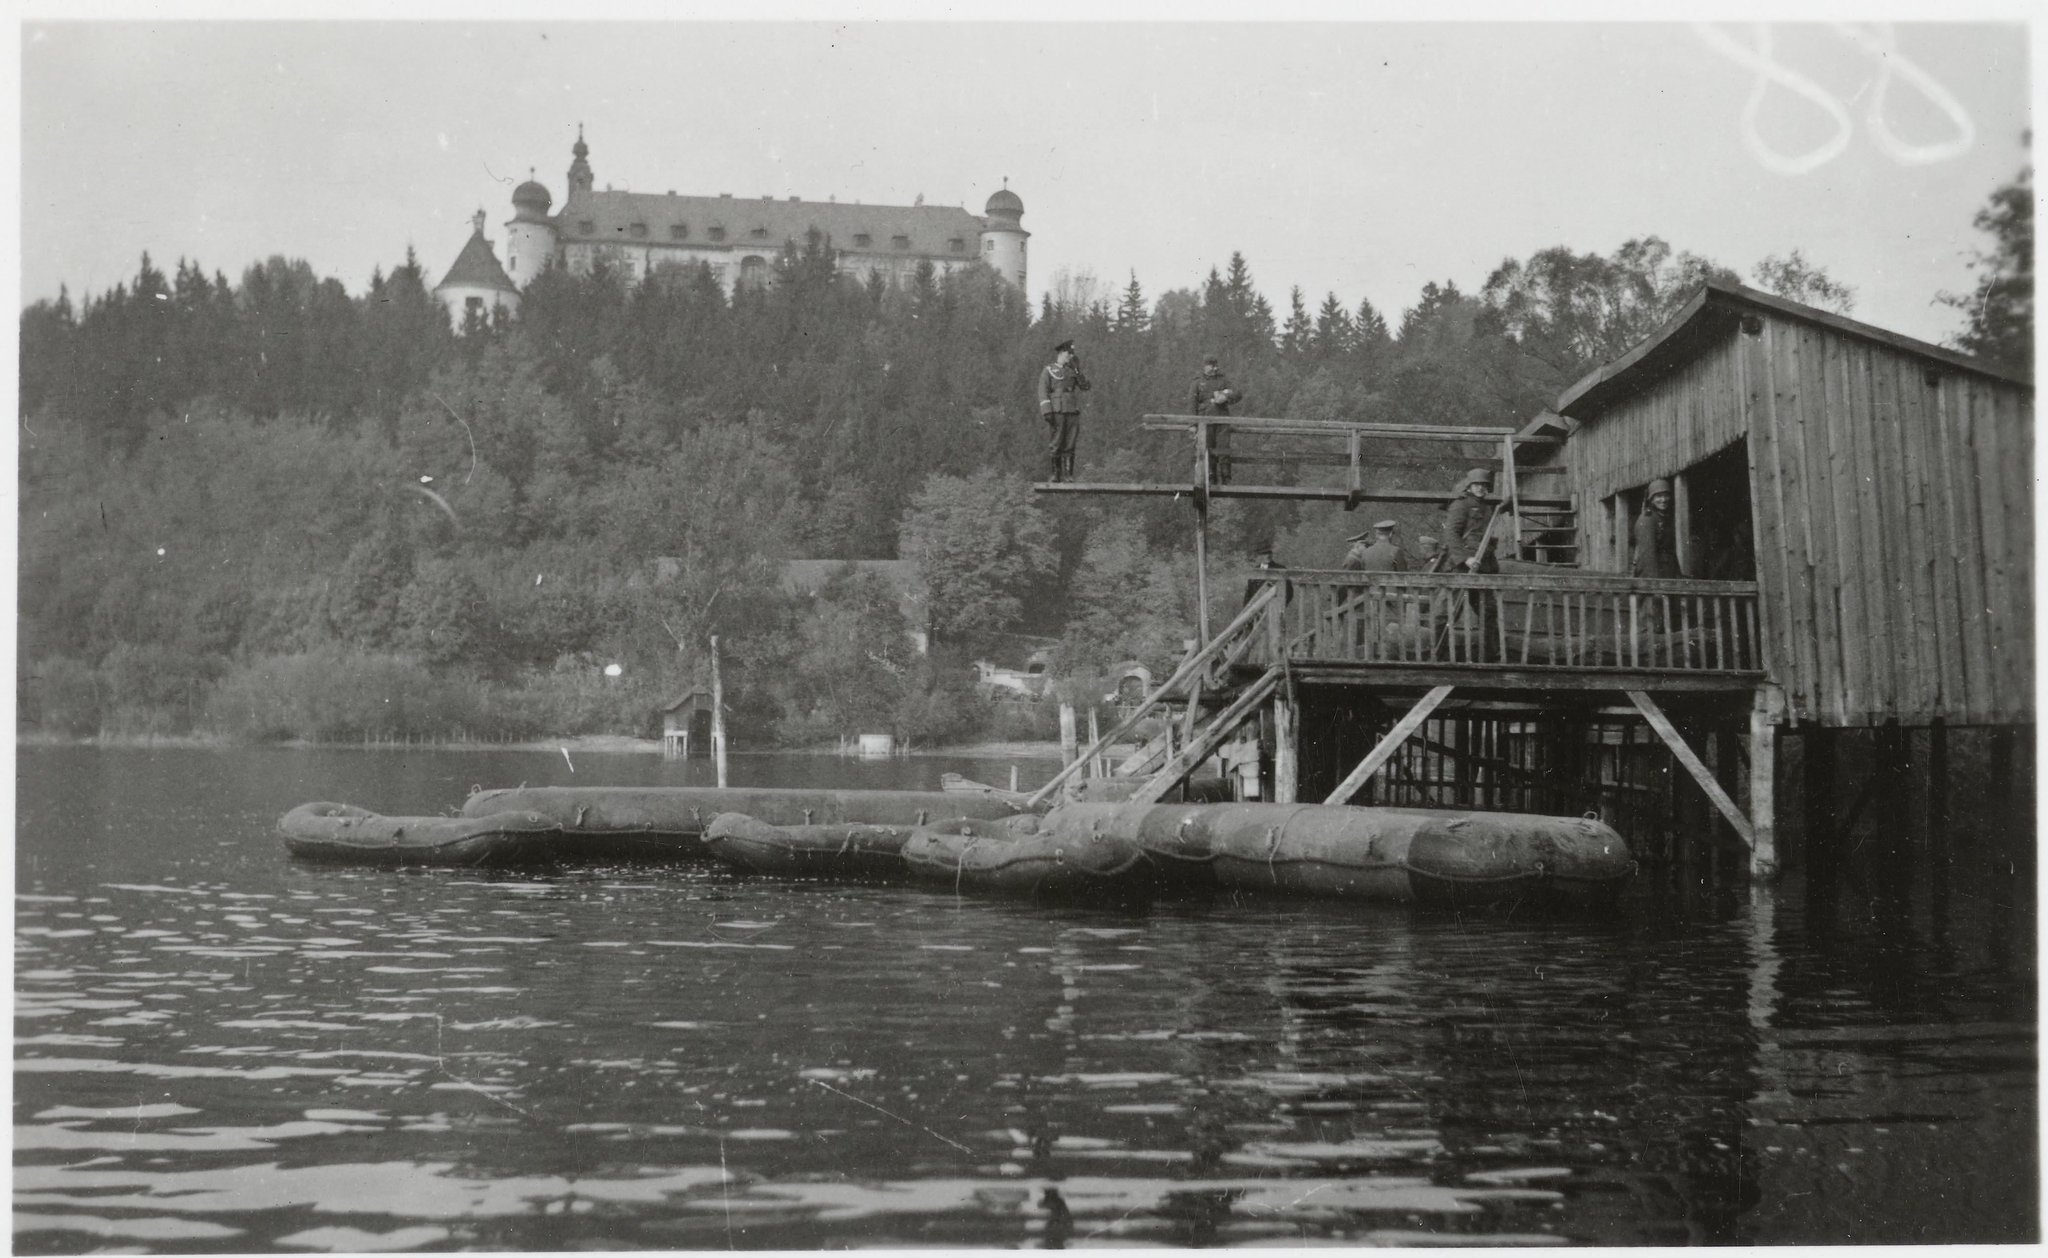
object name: photograph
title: Wehrmachtsoldaten in een houten gebouw aan een rivier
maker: Anonymous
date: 1940-1945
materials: photographic support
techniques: gelatin silver print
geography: france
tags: germany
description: Wehrmachtsoldaten en officieren in een houten gebouw dat in een rivier staat. Voor het houten gebouw liggen opblaasboten. Op een heuvel staat een kasteel. Foto behorend bij album 'Kriegserinnerungen'.